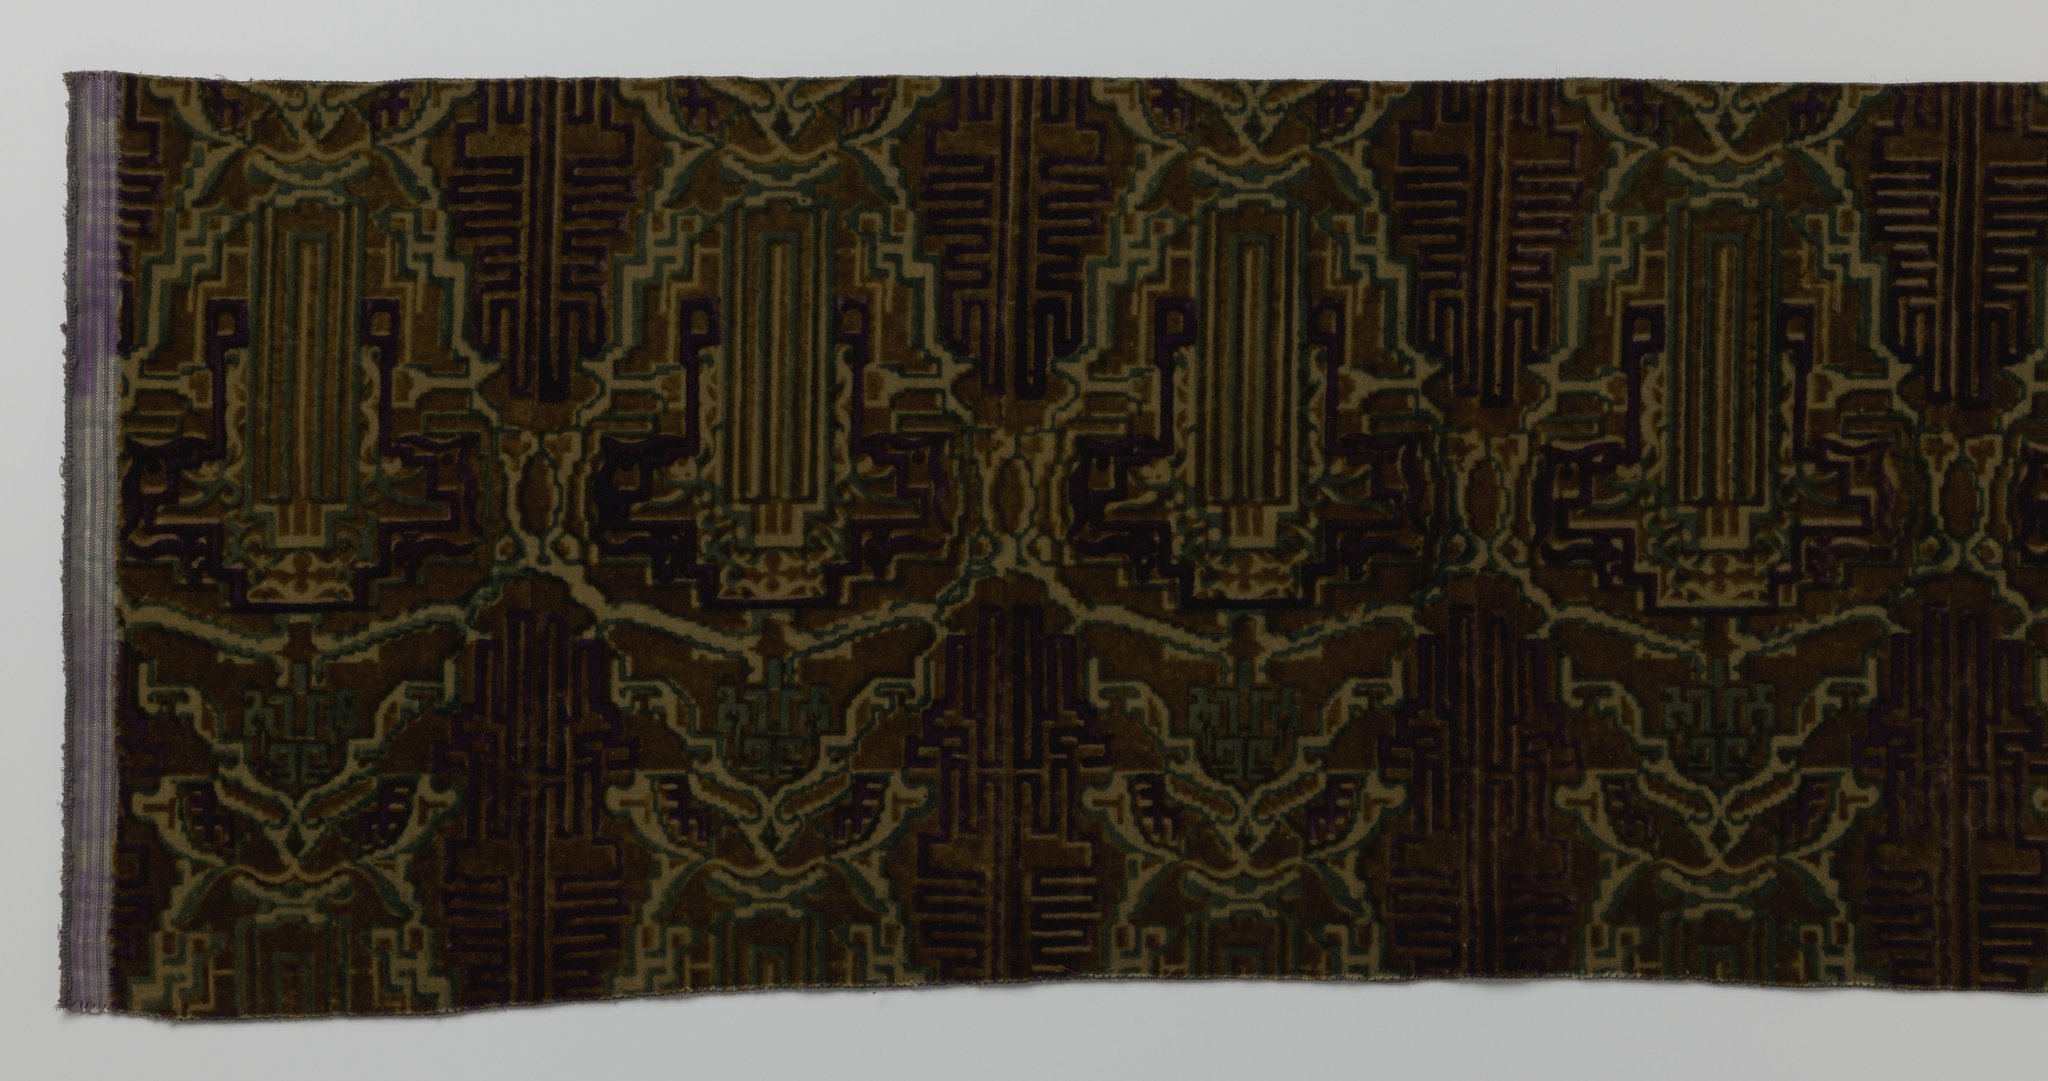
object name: bekledingsstof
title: Bekleding- of bespanningsstof van bedrukte trijp met dessin "Toreador"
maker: carel adolph lion cachet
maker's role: draughtsman, print maker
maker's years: 1864-1945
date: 1920-1925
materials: cotton, textile, hair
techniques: printing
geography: eindhoven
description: Bekleding- of bespanningsstof, handbedrukte trijp, meanderend patroon in violet en lichtgroen op beige fond. Dessin "Toreador".